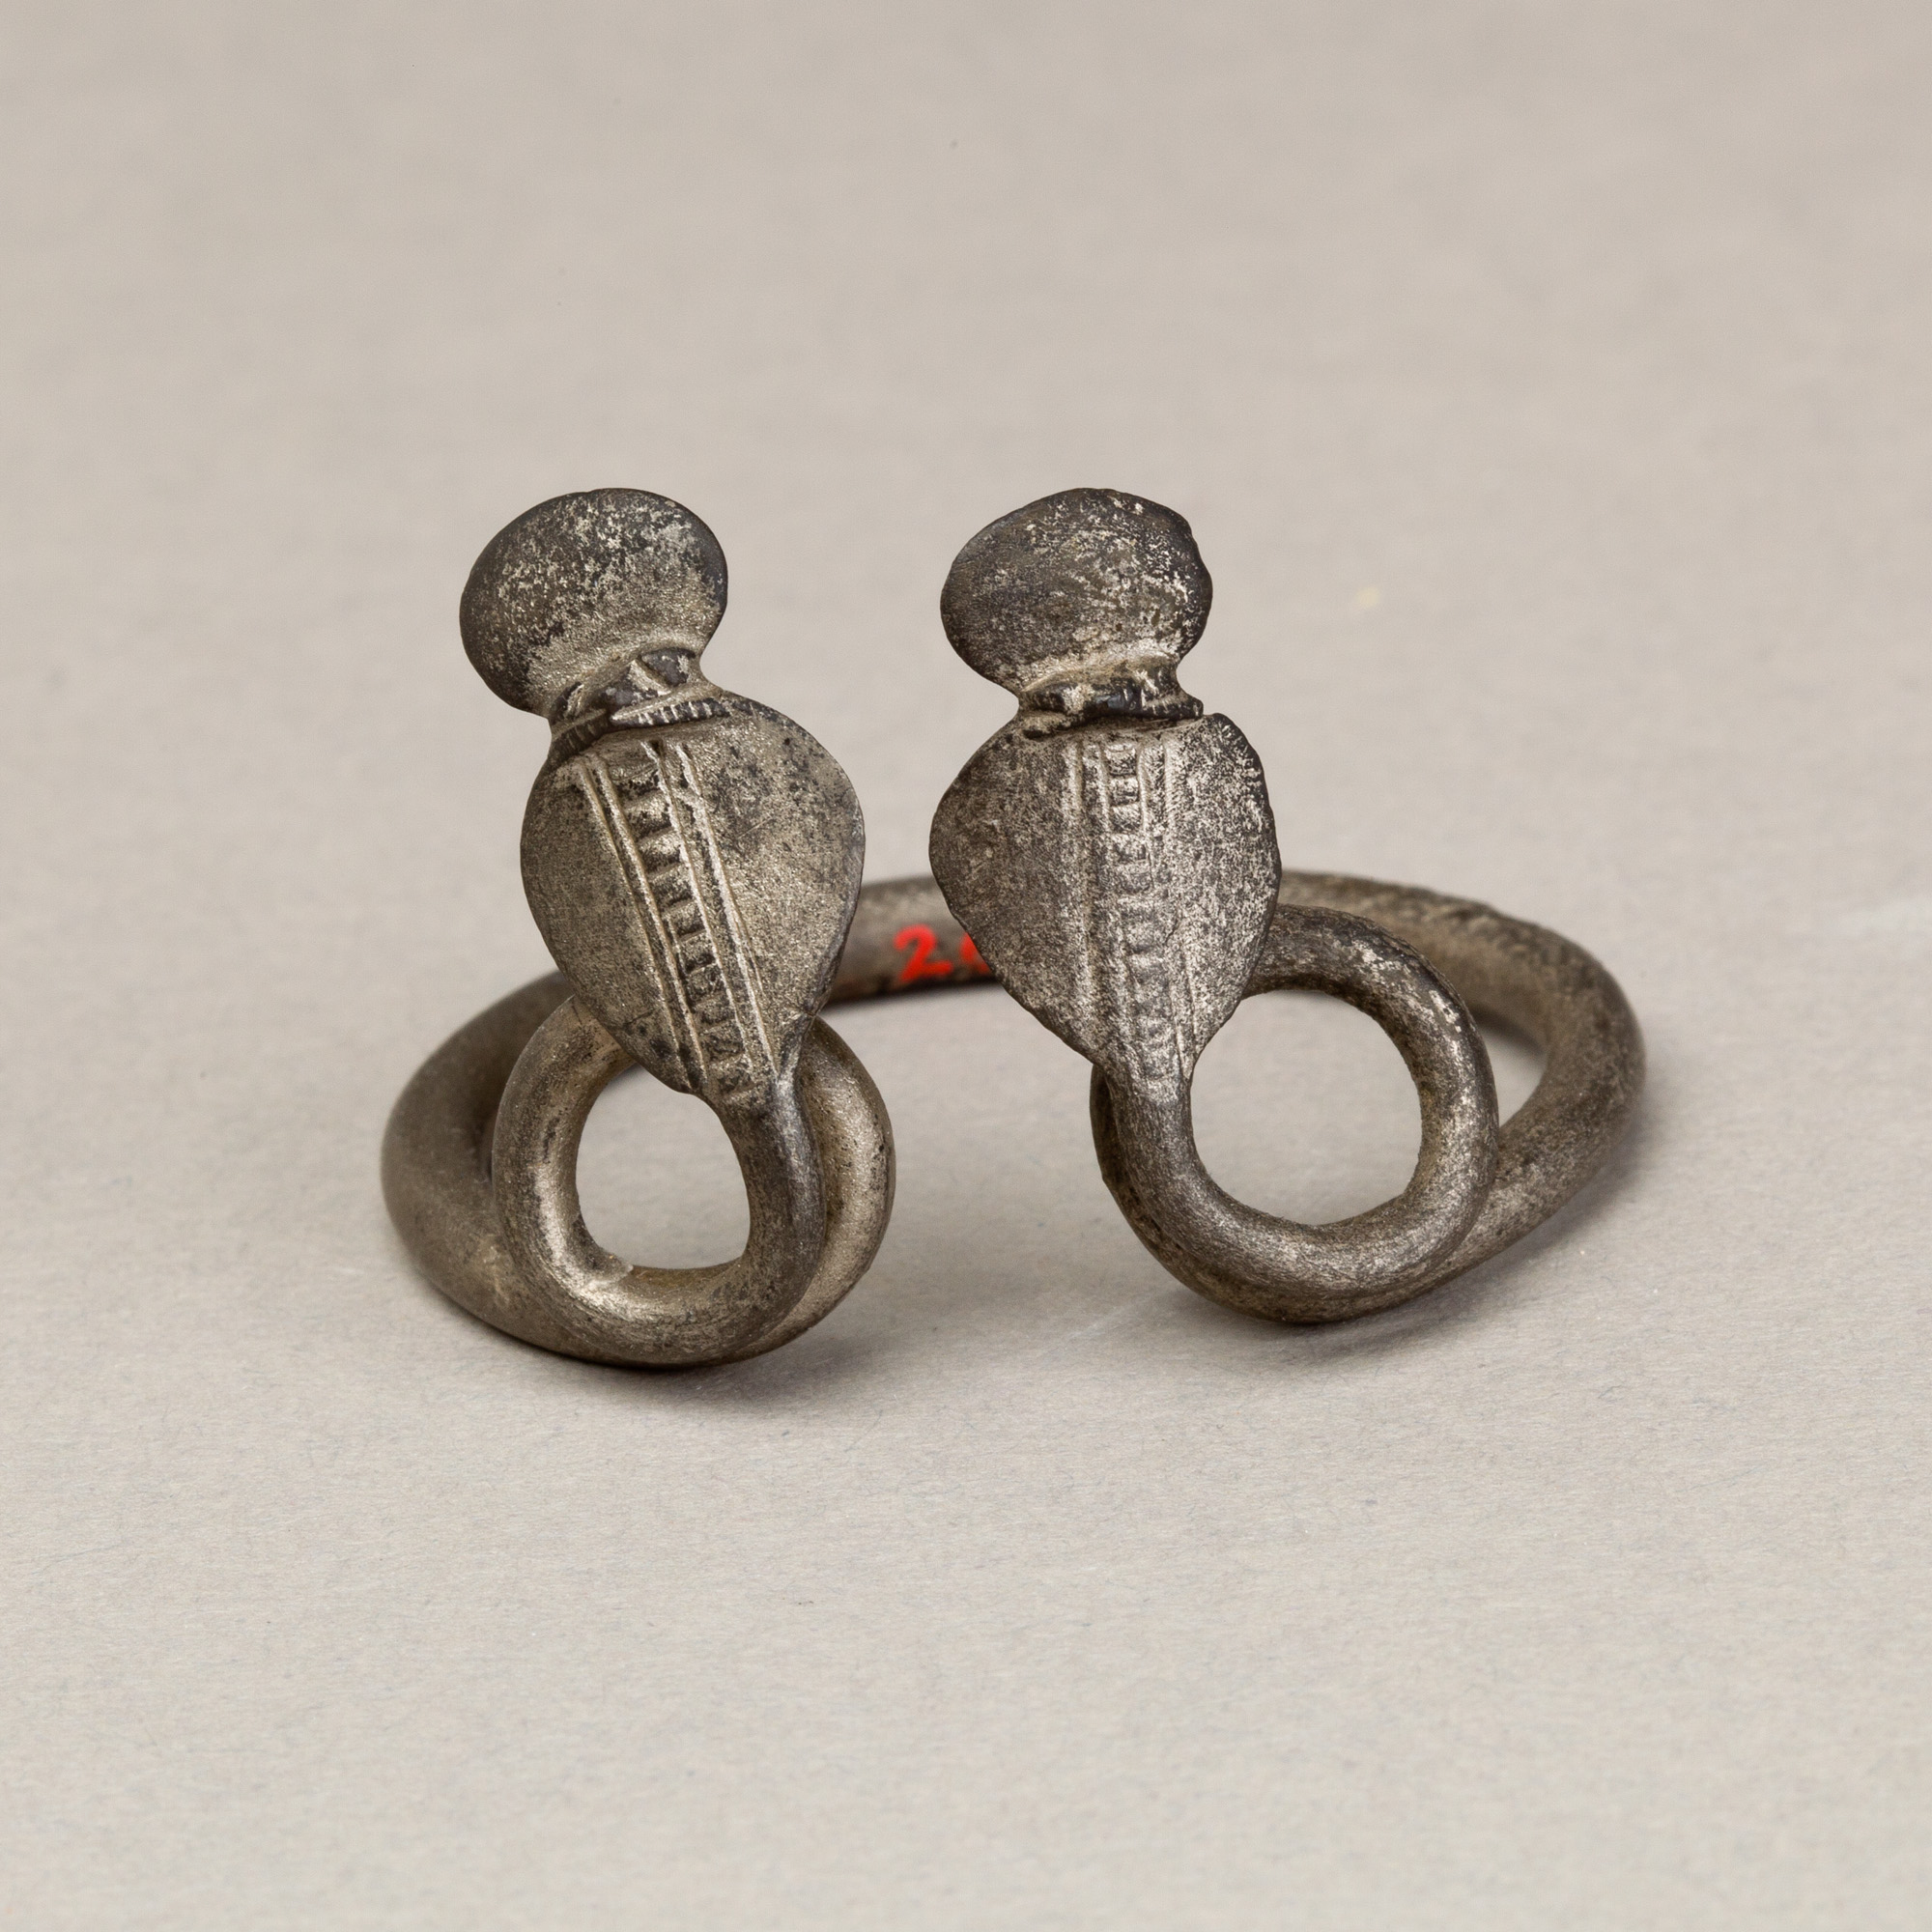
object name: bracelet, uraei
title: Bracelet with two uraei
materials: silver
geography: egypt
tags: serpents